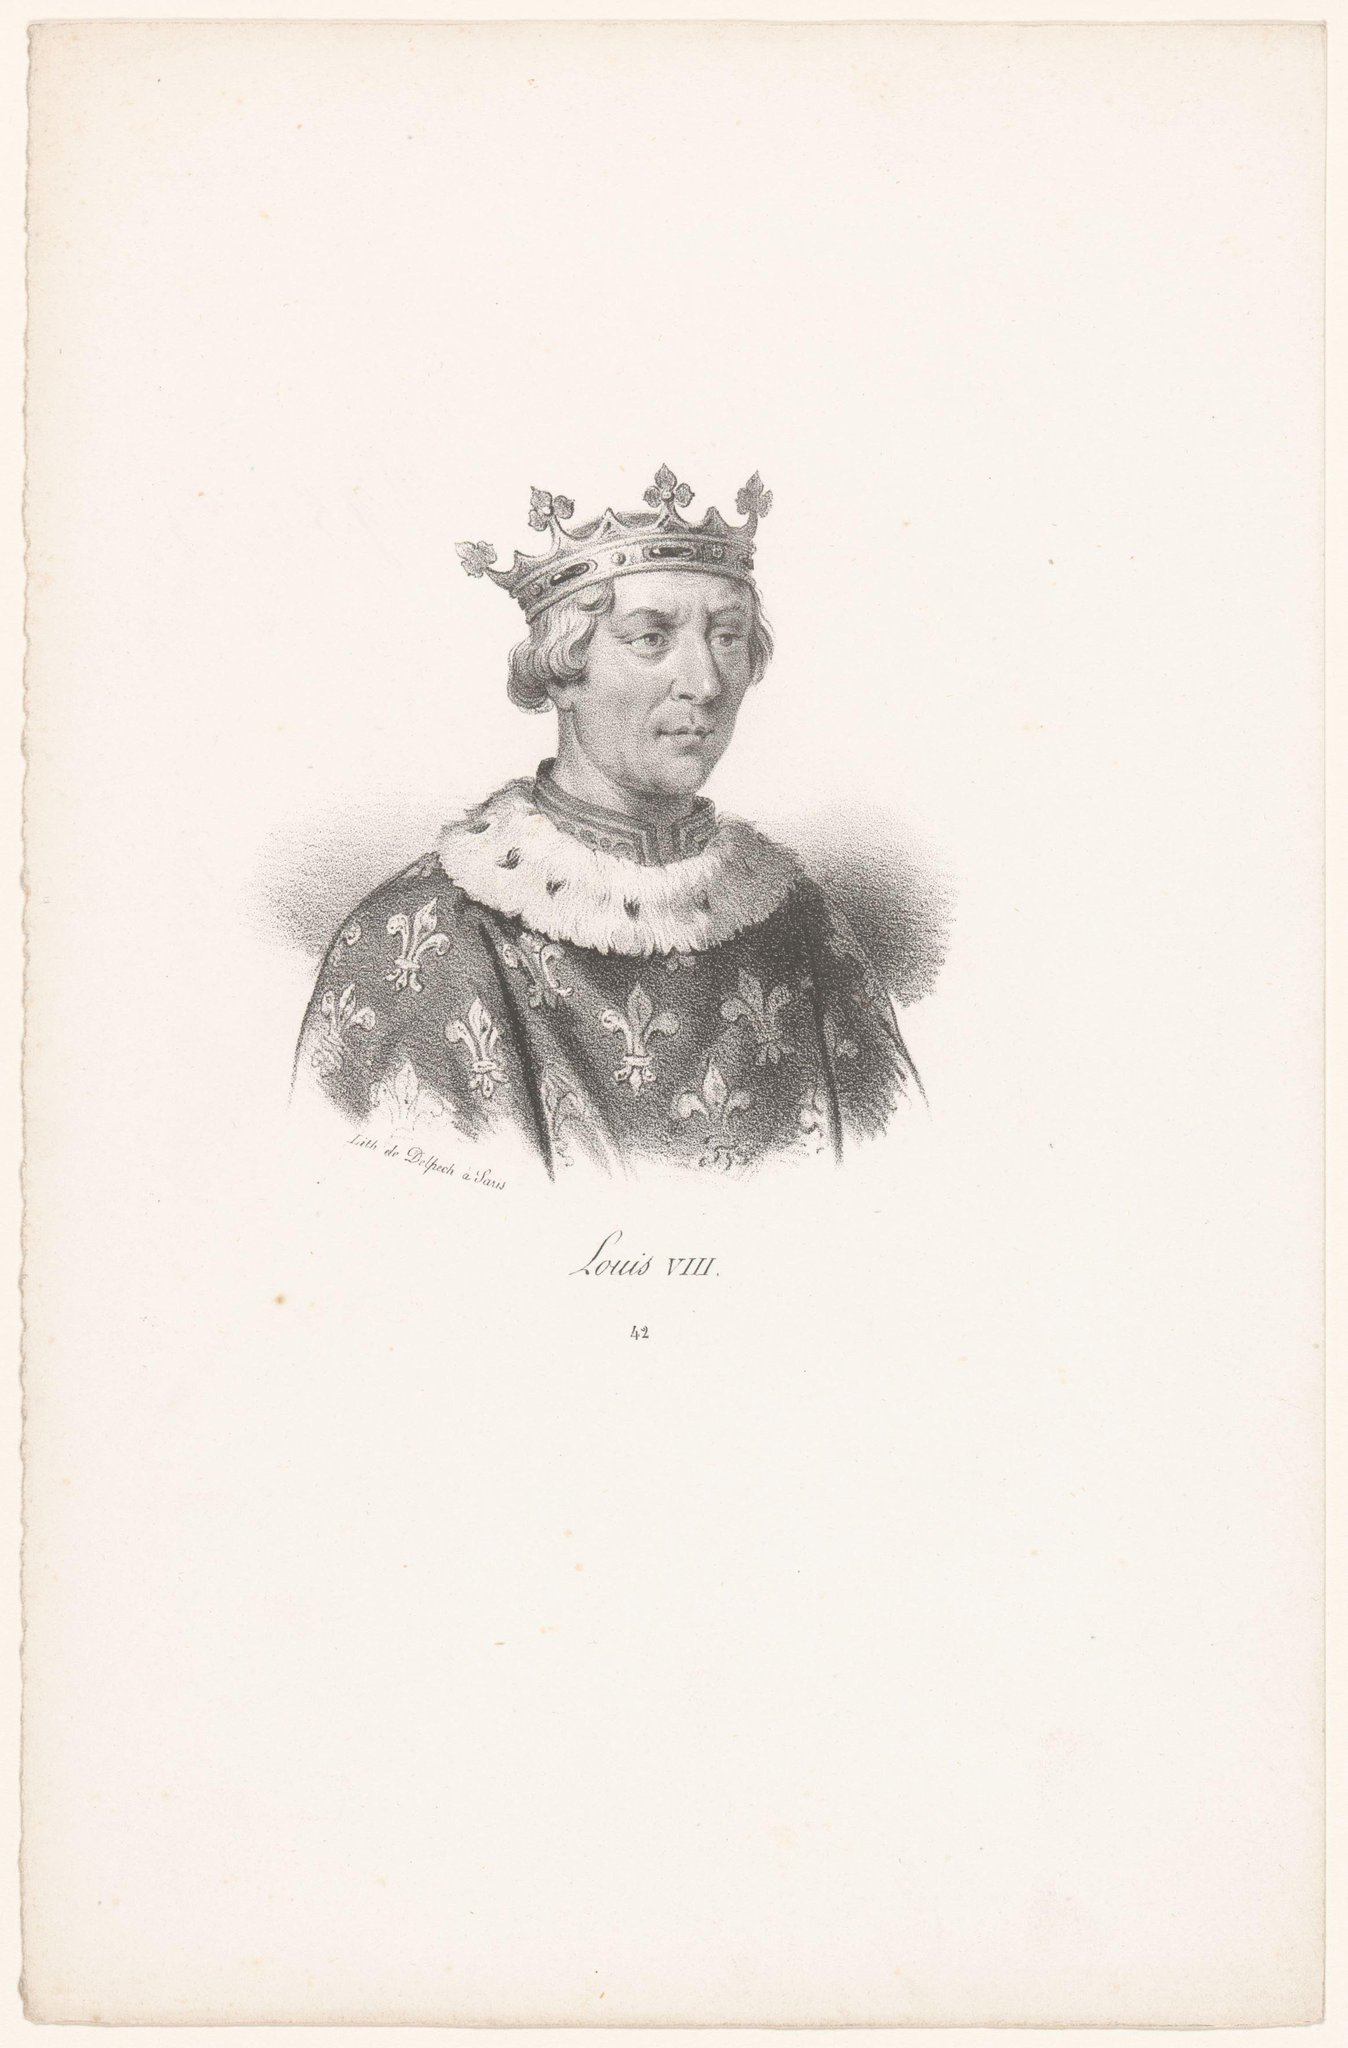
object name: print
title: Louis VIII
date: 1818-1842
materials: paper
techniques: lithograph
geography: paris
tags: paris, historical persons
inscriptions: collector's mark: Lugt 2228a